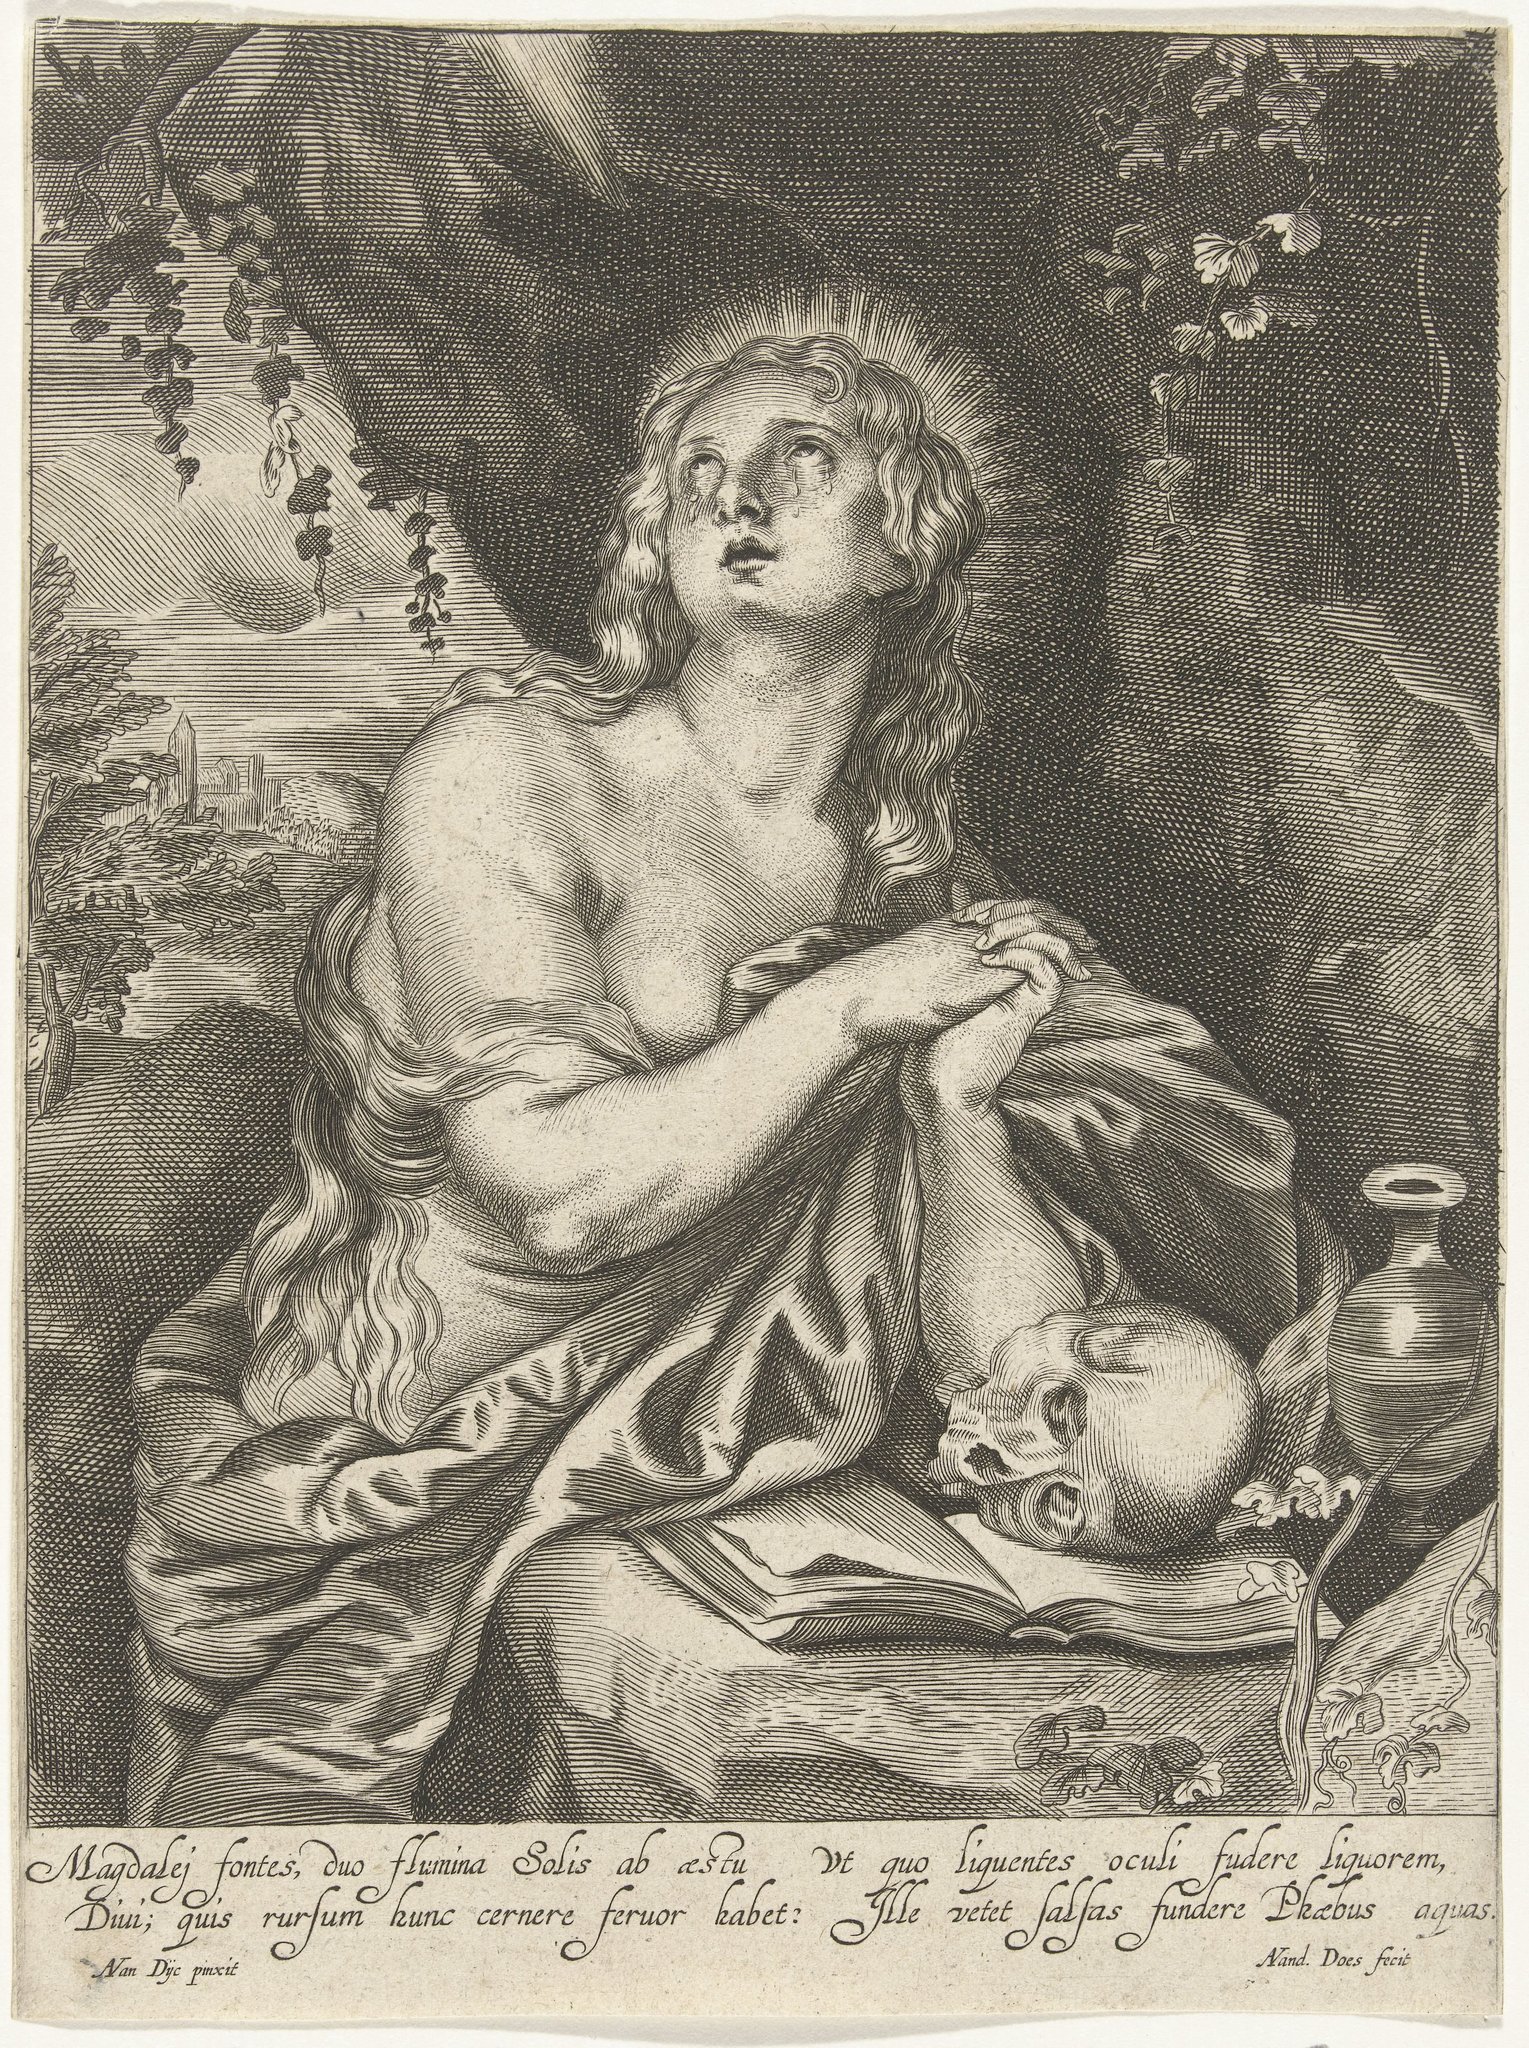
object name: print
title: Maria Magdalena in de woestijn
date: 1619-1680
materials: paper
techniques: engraving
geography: southern netherlands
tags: the penitent st. mary magdalene (often before a cave, possibly at la sainte-baume hill): her long hair covers her (naked) body, she reads, meditates or raises her tear-filled eyes towards heaven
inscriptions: collector's mark: Lugt 240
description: Maria Magdalena als boetvaardige in de woestijn knielend in gebed bij opengeslagen bijbel. In ondermarge twee regels Latijns.